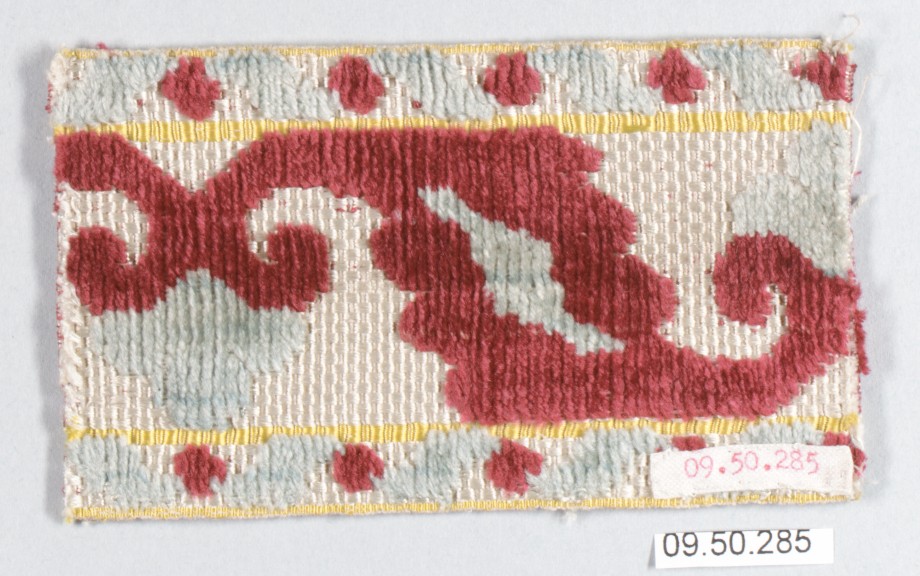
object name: galloon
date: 1701-1800